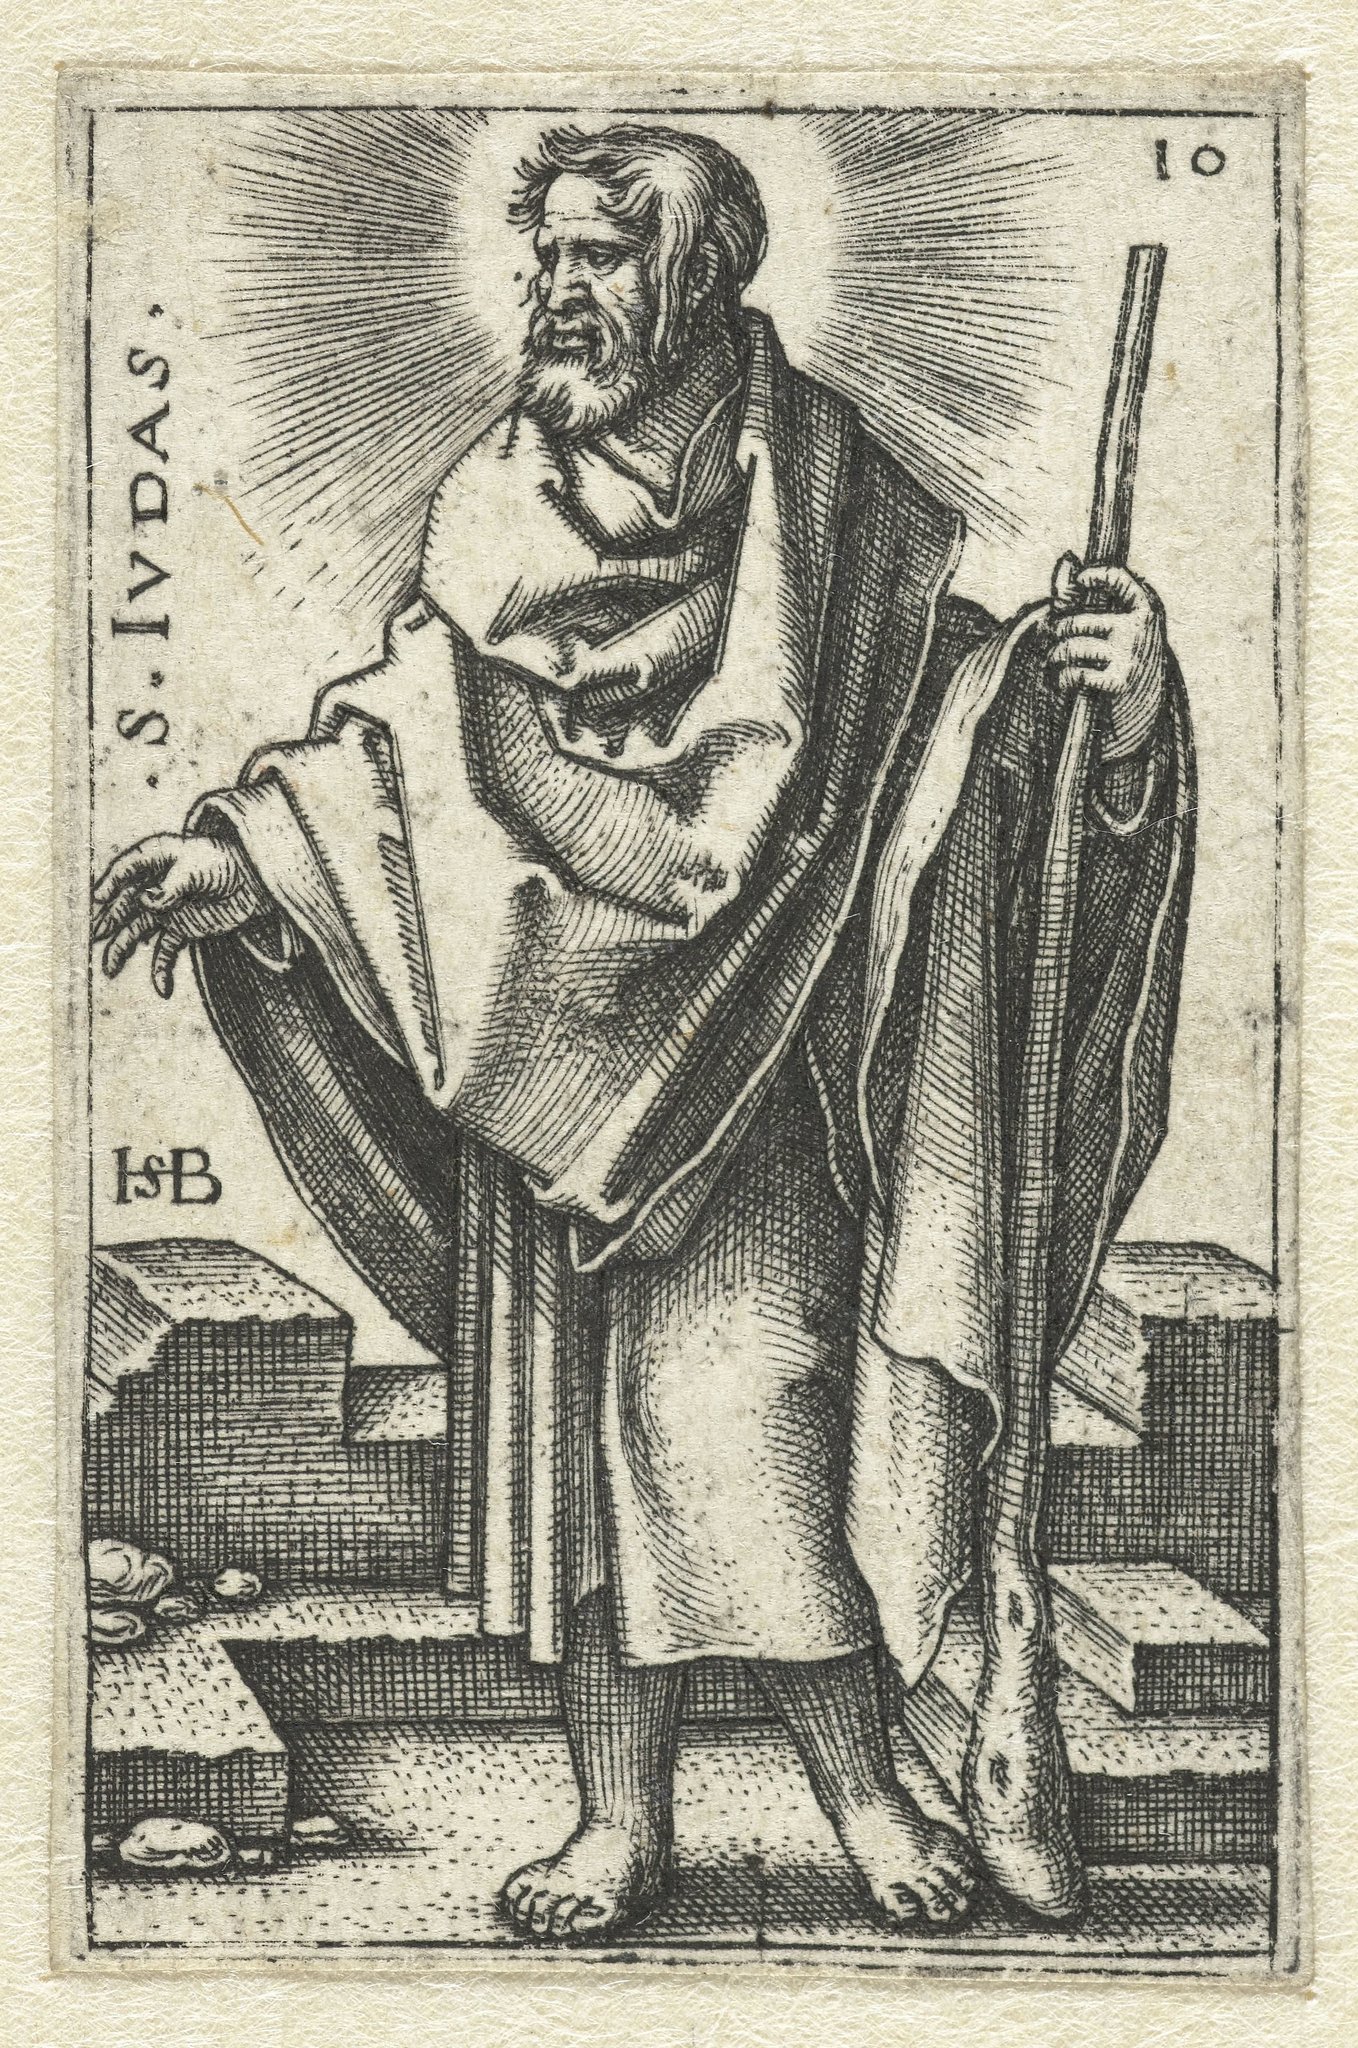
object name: print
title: Twaalf Apostelen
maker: hans sebald beham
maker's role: designer, draughtsman, print maker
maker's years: 1500-1550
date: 1545-1546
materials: paper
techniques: engraving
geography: frankfurt am main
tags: the apostle jude thaddaeus; possible attributes: book, club, halberd, scroll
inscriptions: collector's mark: Lugt 2228a